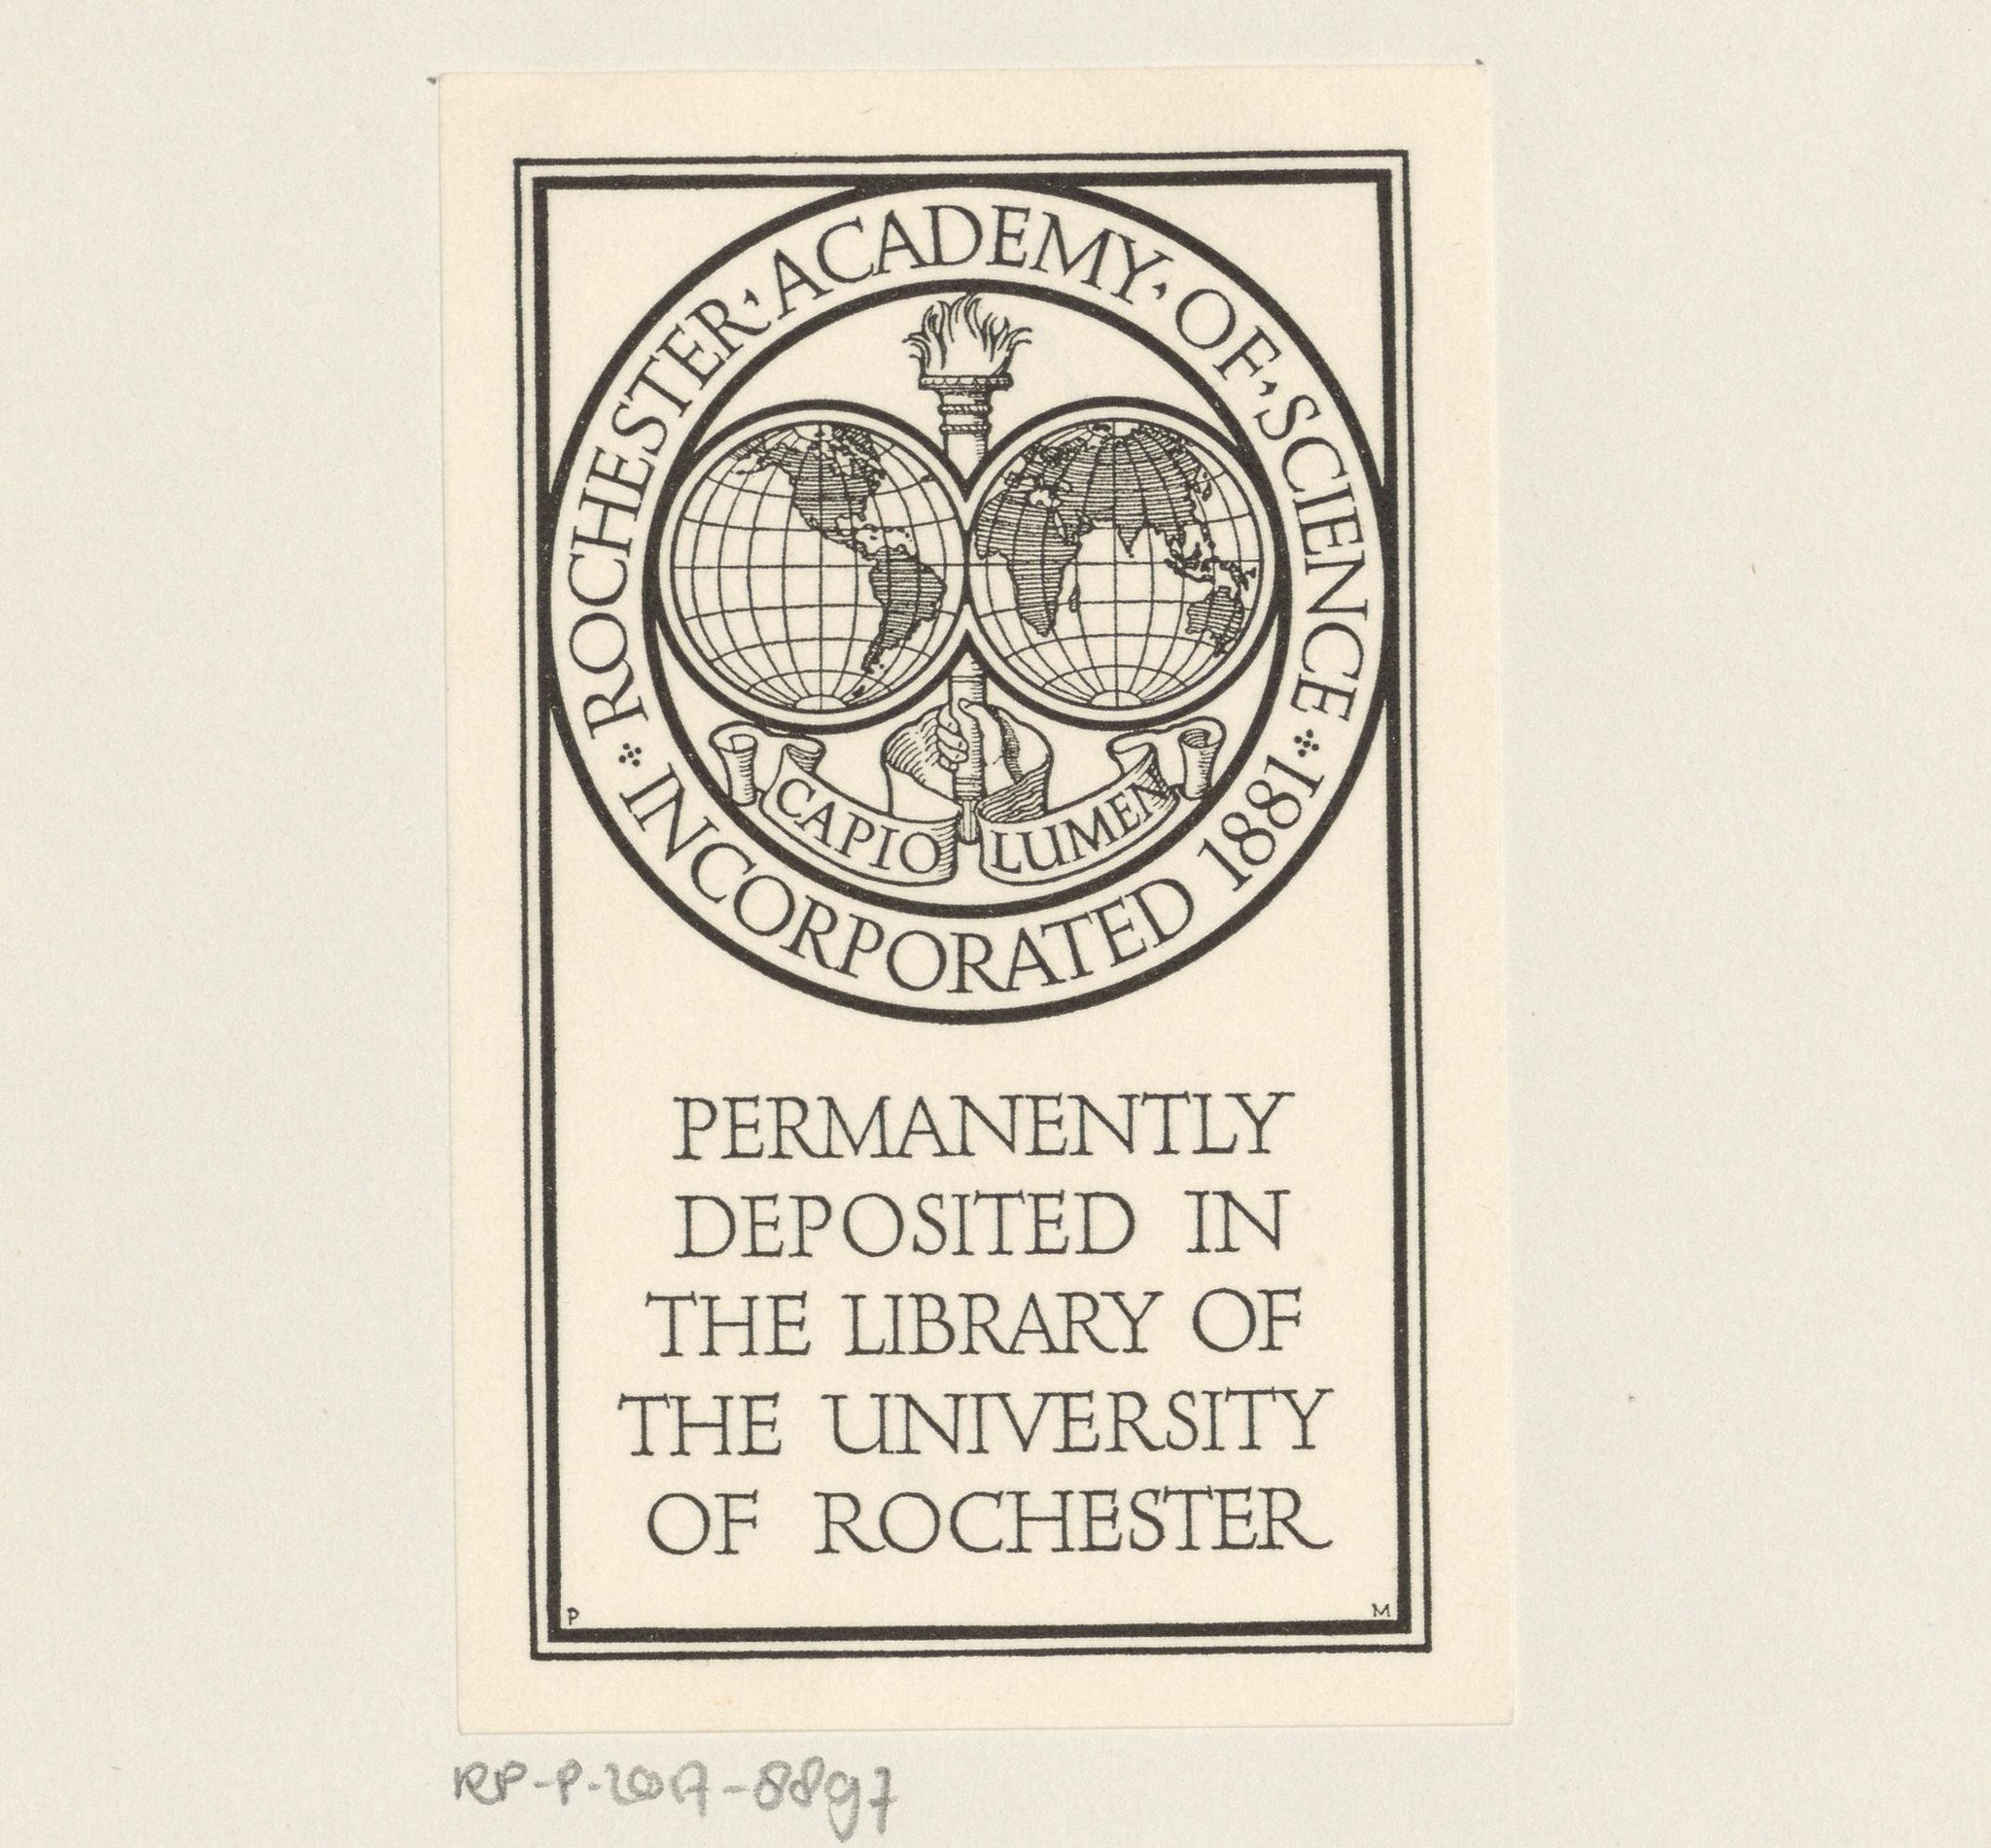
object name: bookplate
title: Ex libris van de University of Rochester Library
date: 1900-1999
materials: paper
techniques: printing block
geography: north and central america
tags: university, torch, globe